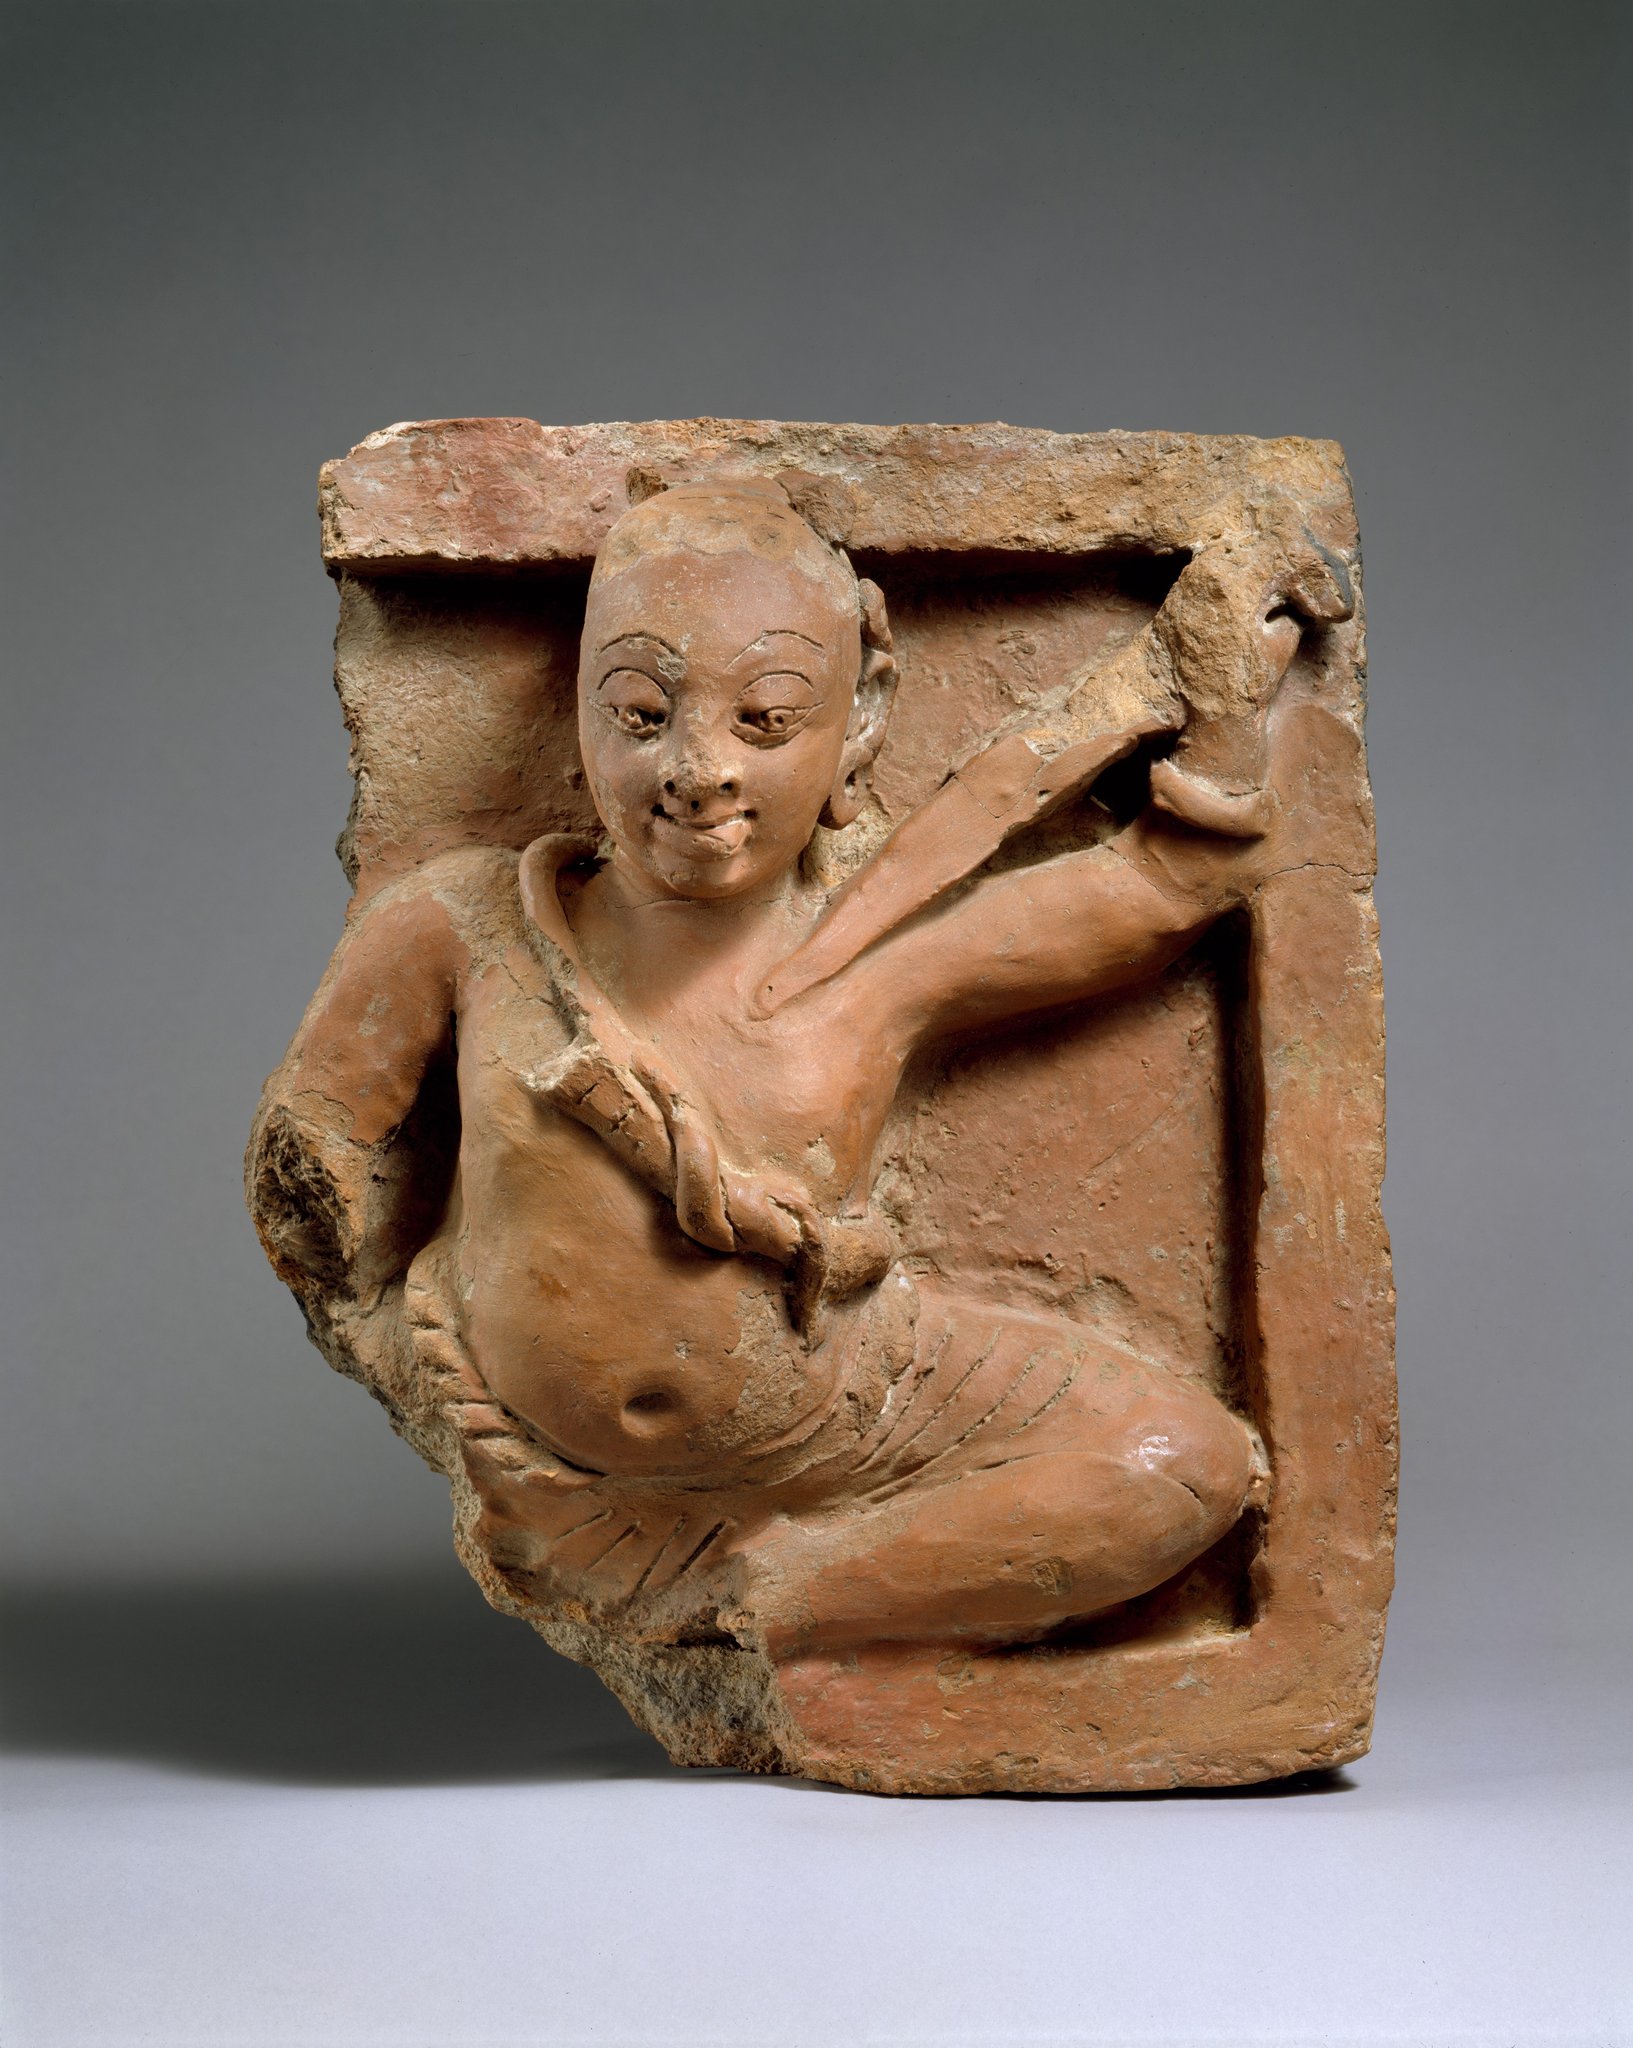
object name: plaque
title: Plaque with Figure Holding a Sword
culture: indian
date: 401-500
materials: terracotta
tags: gupta,swords,men